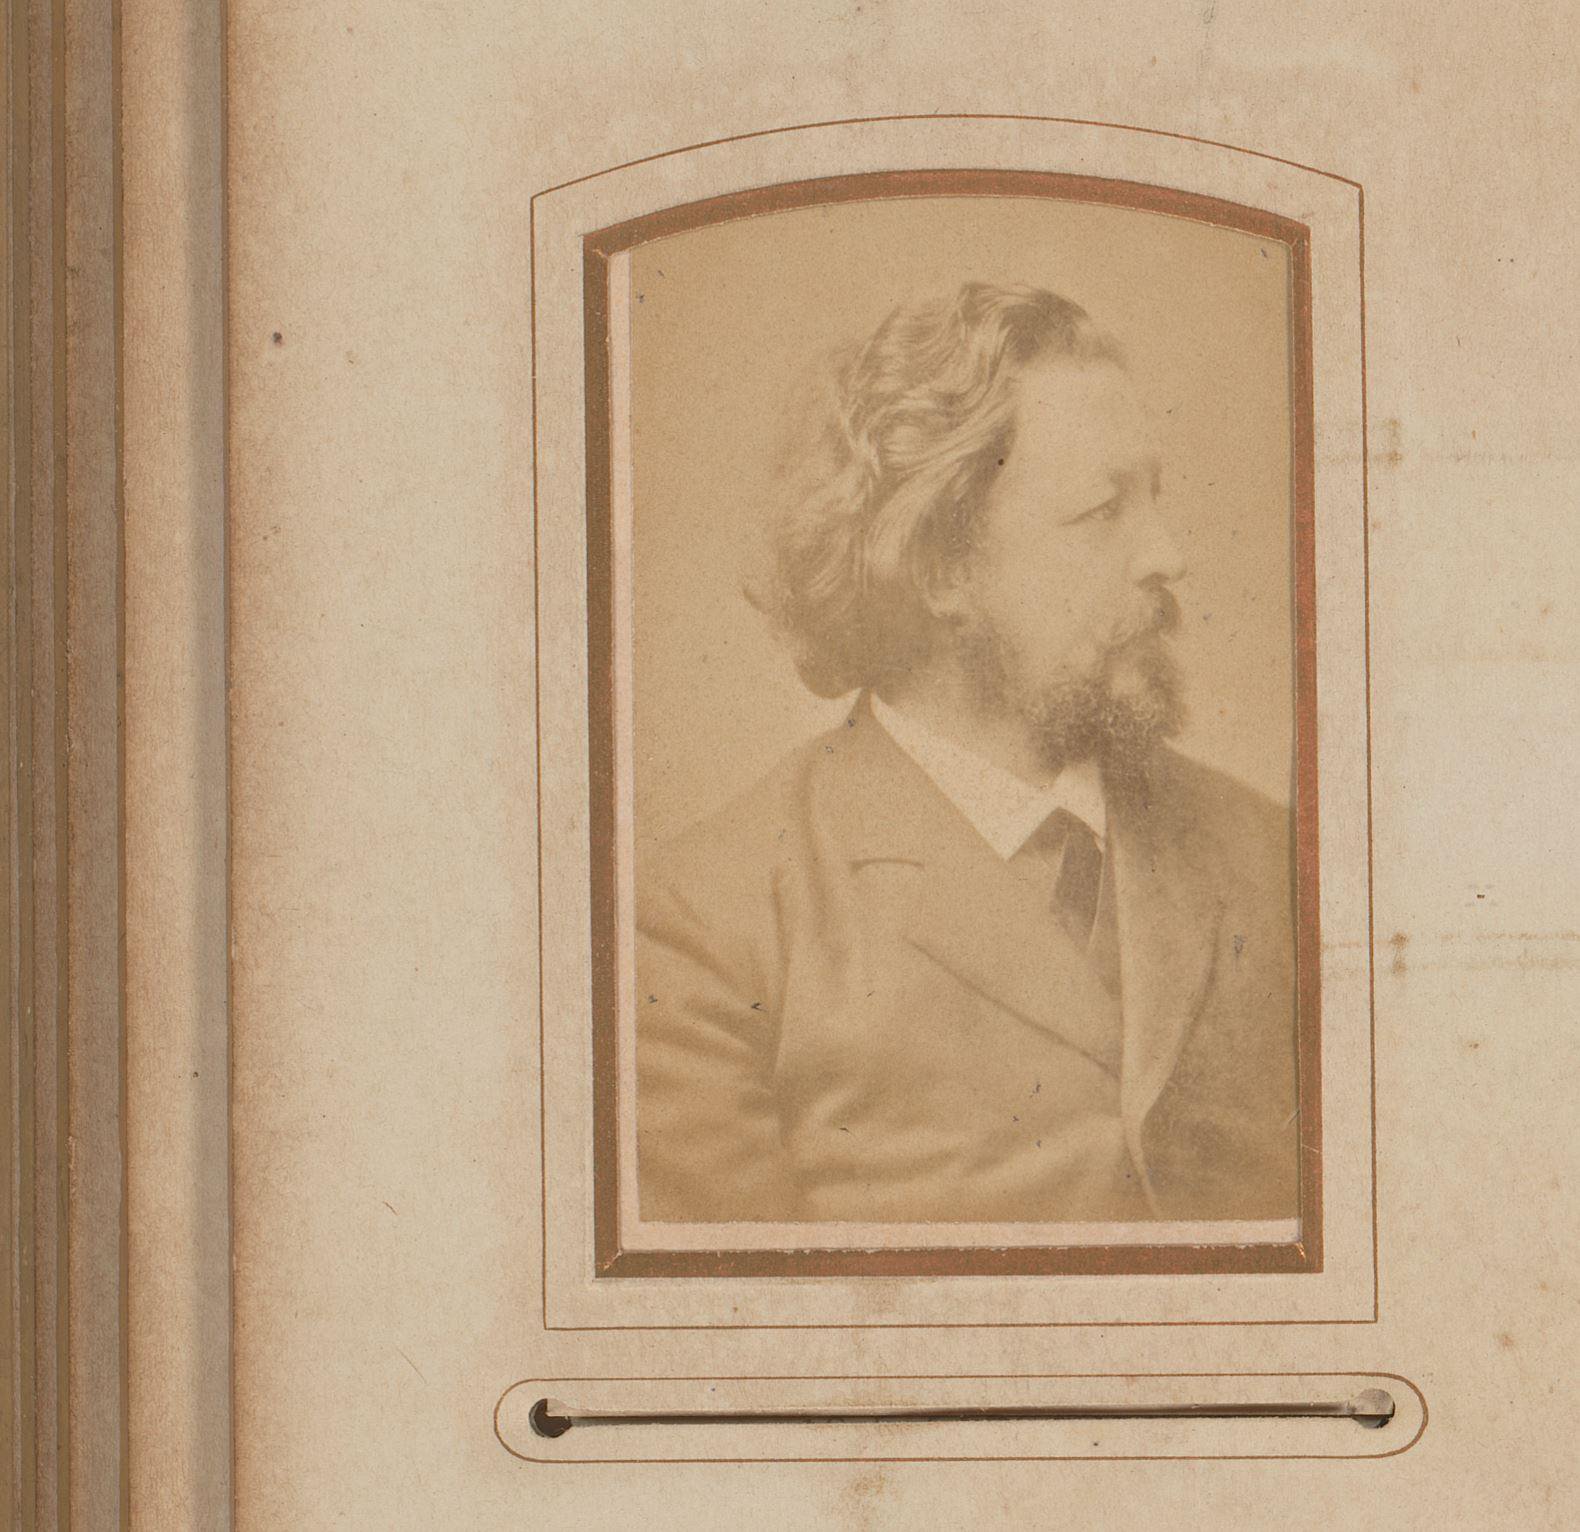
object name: album leaf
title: Portret van Paul Heyse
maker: Anonymous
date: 1865-1885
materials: cardboard, photographic support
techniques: albumen print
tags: berlin, historical persons, portrait of a writer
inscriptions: inscription: ‘Paul Heyse:/ 1[3]34’, inscription: ‘[P].’